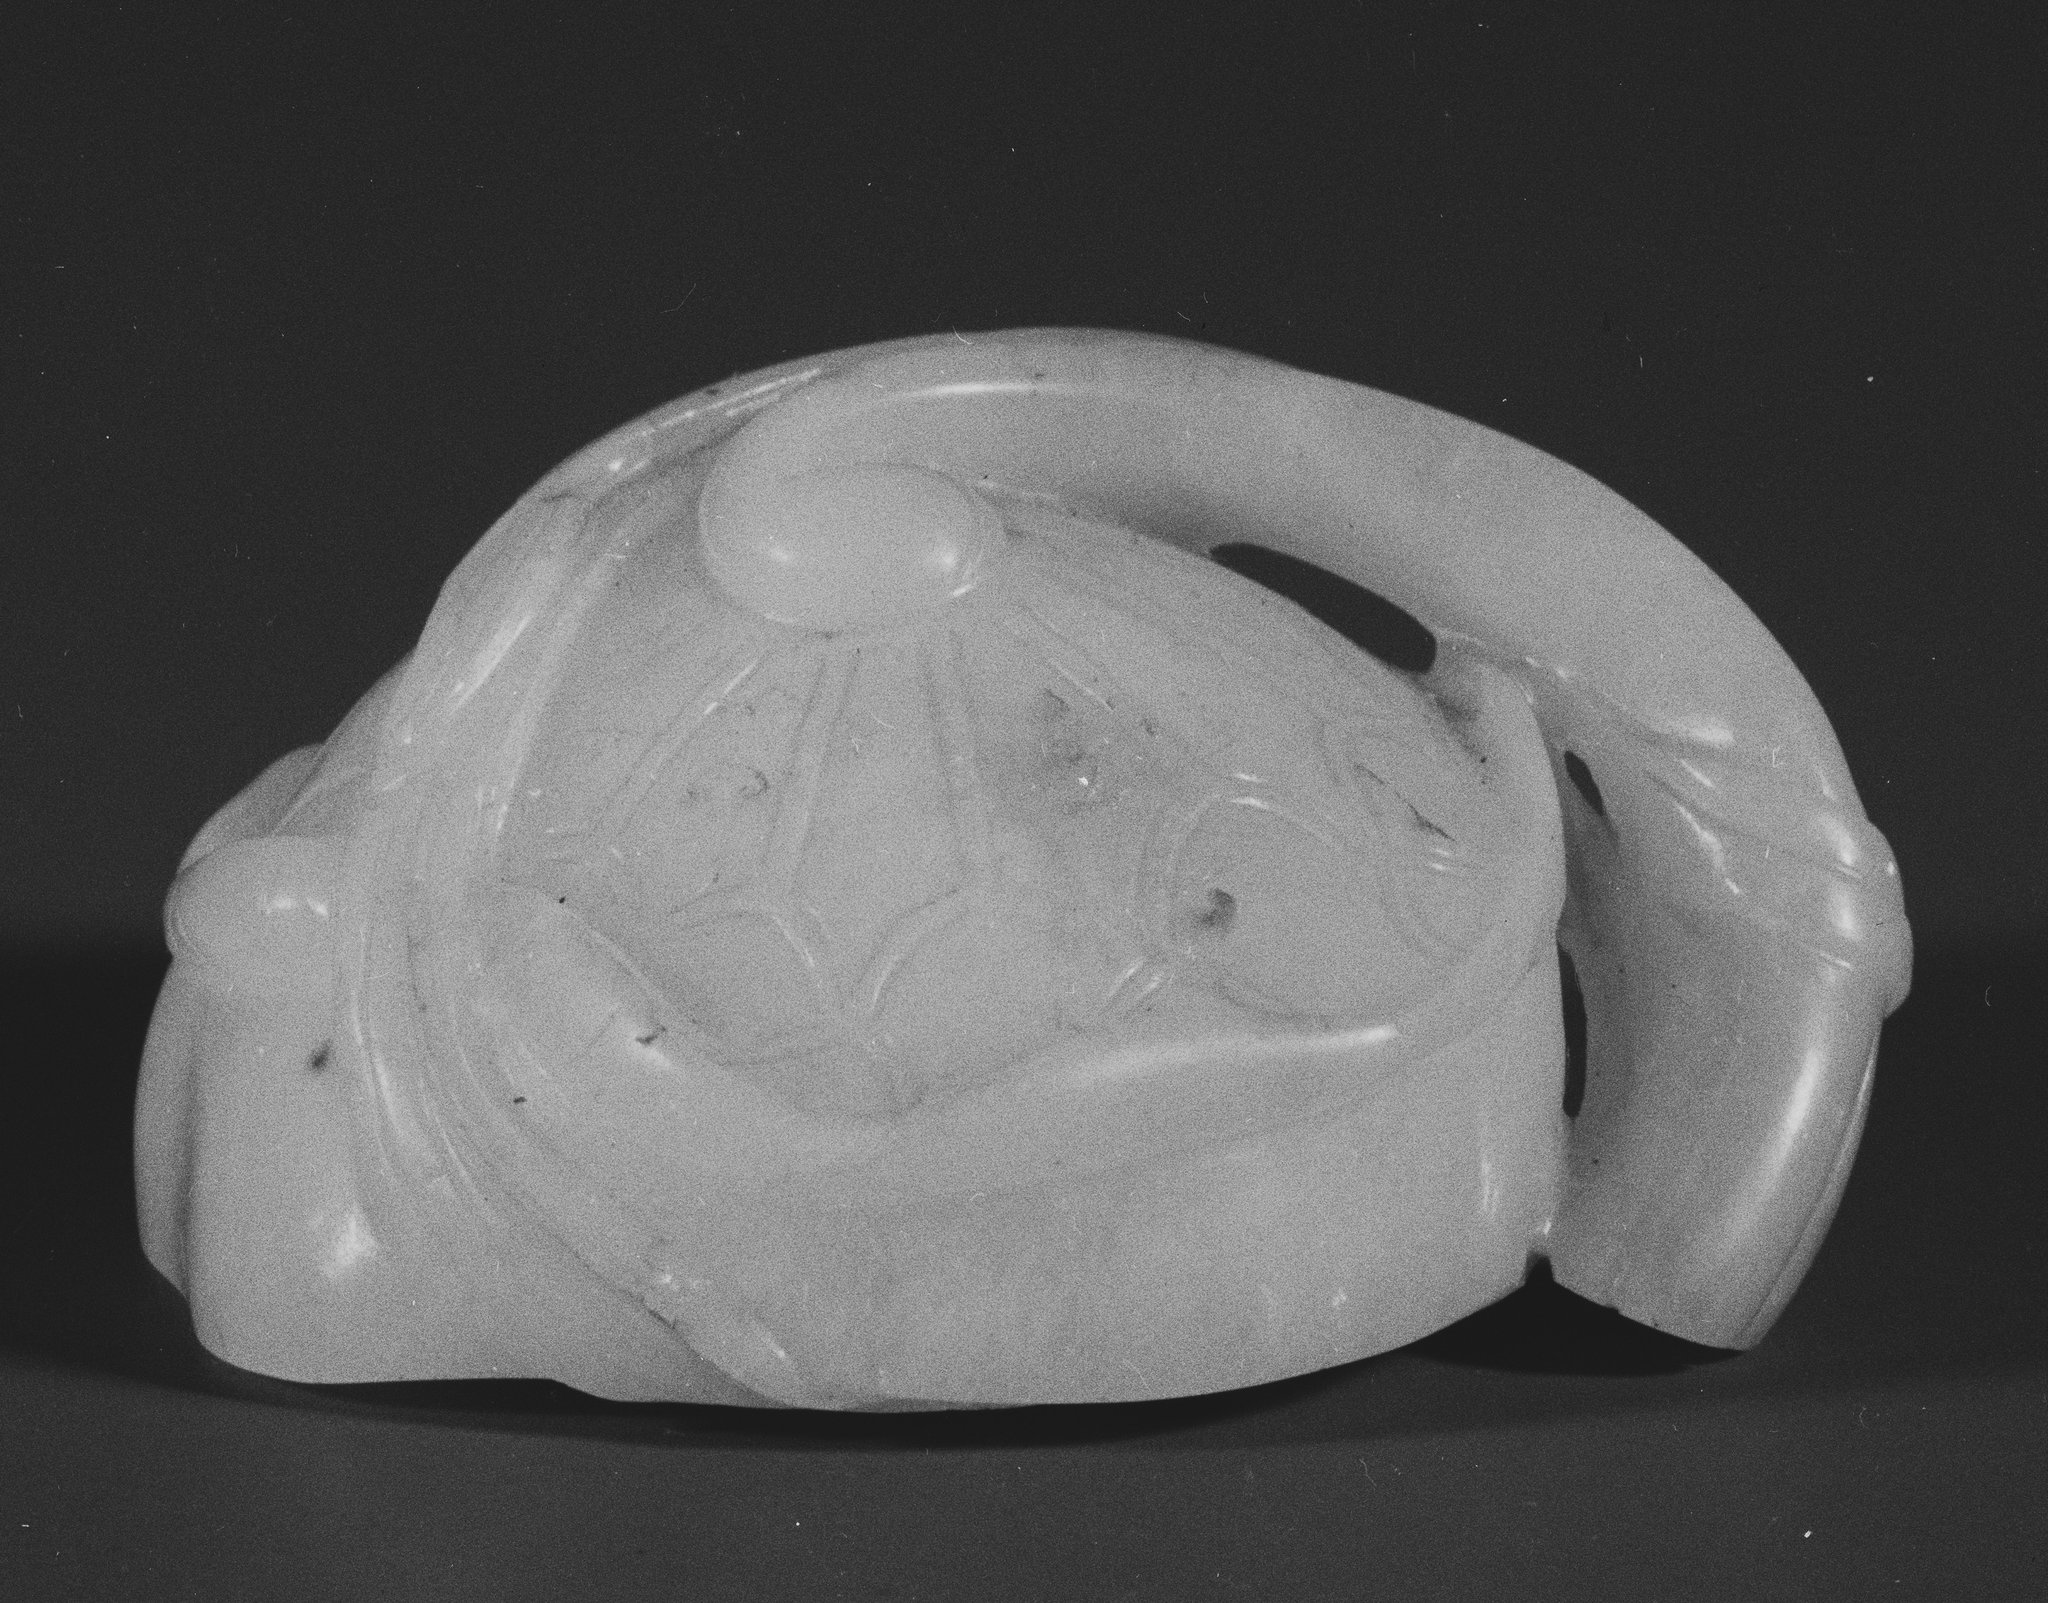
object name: toggle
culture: chinese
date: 1601-1700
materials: jade